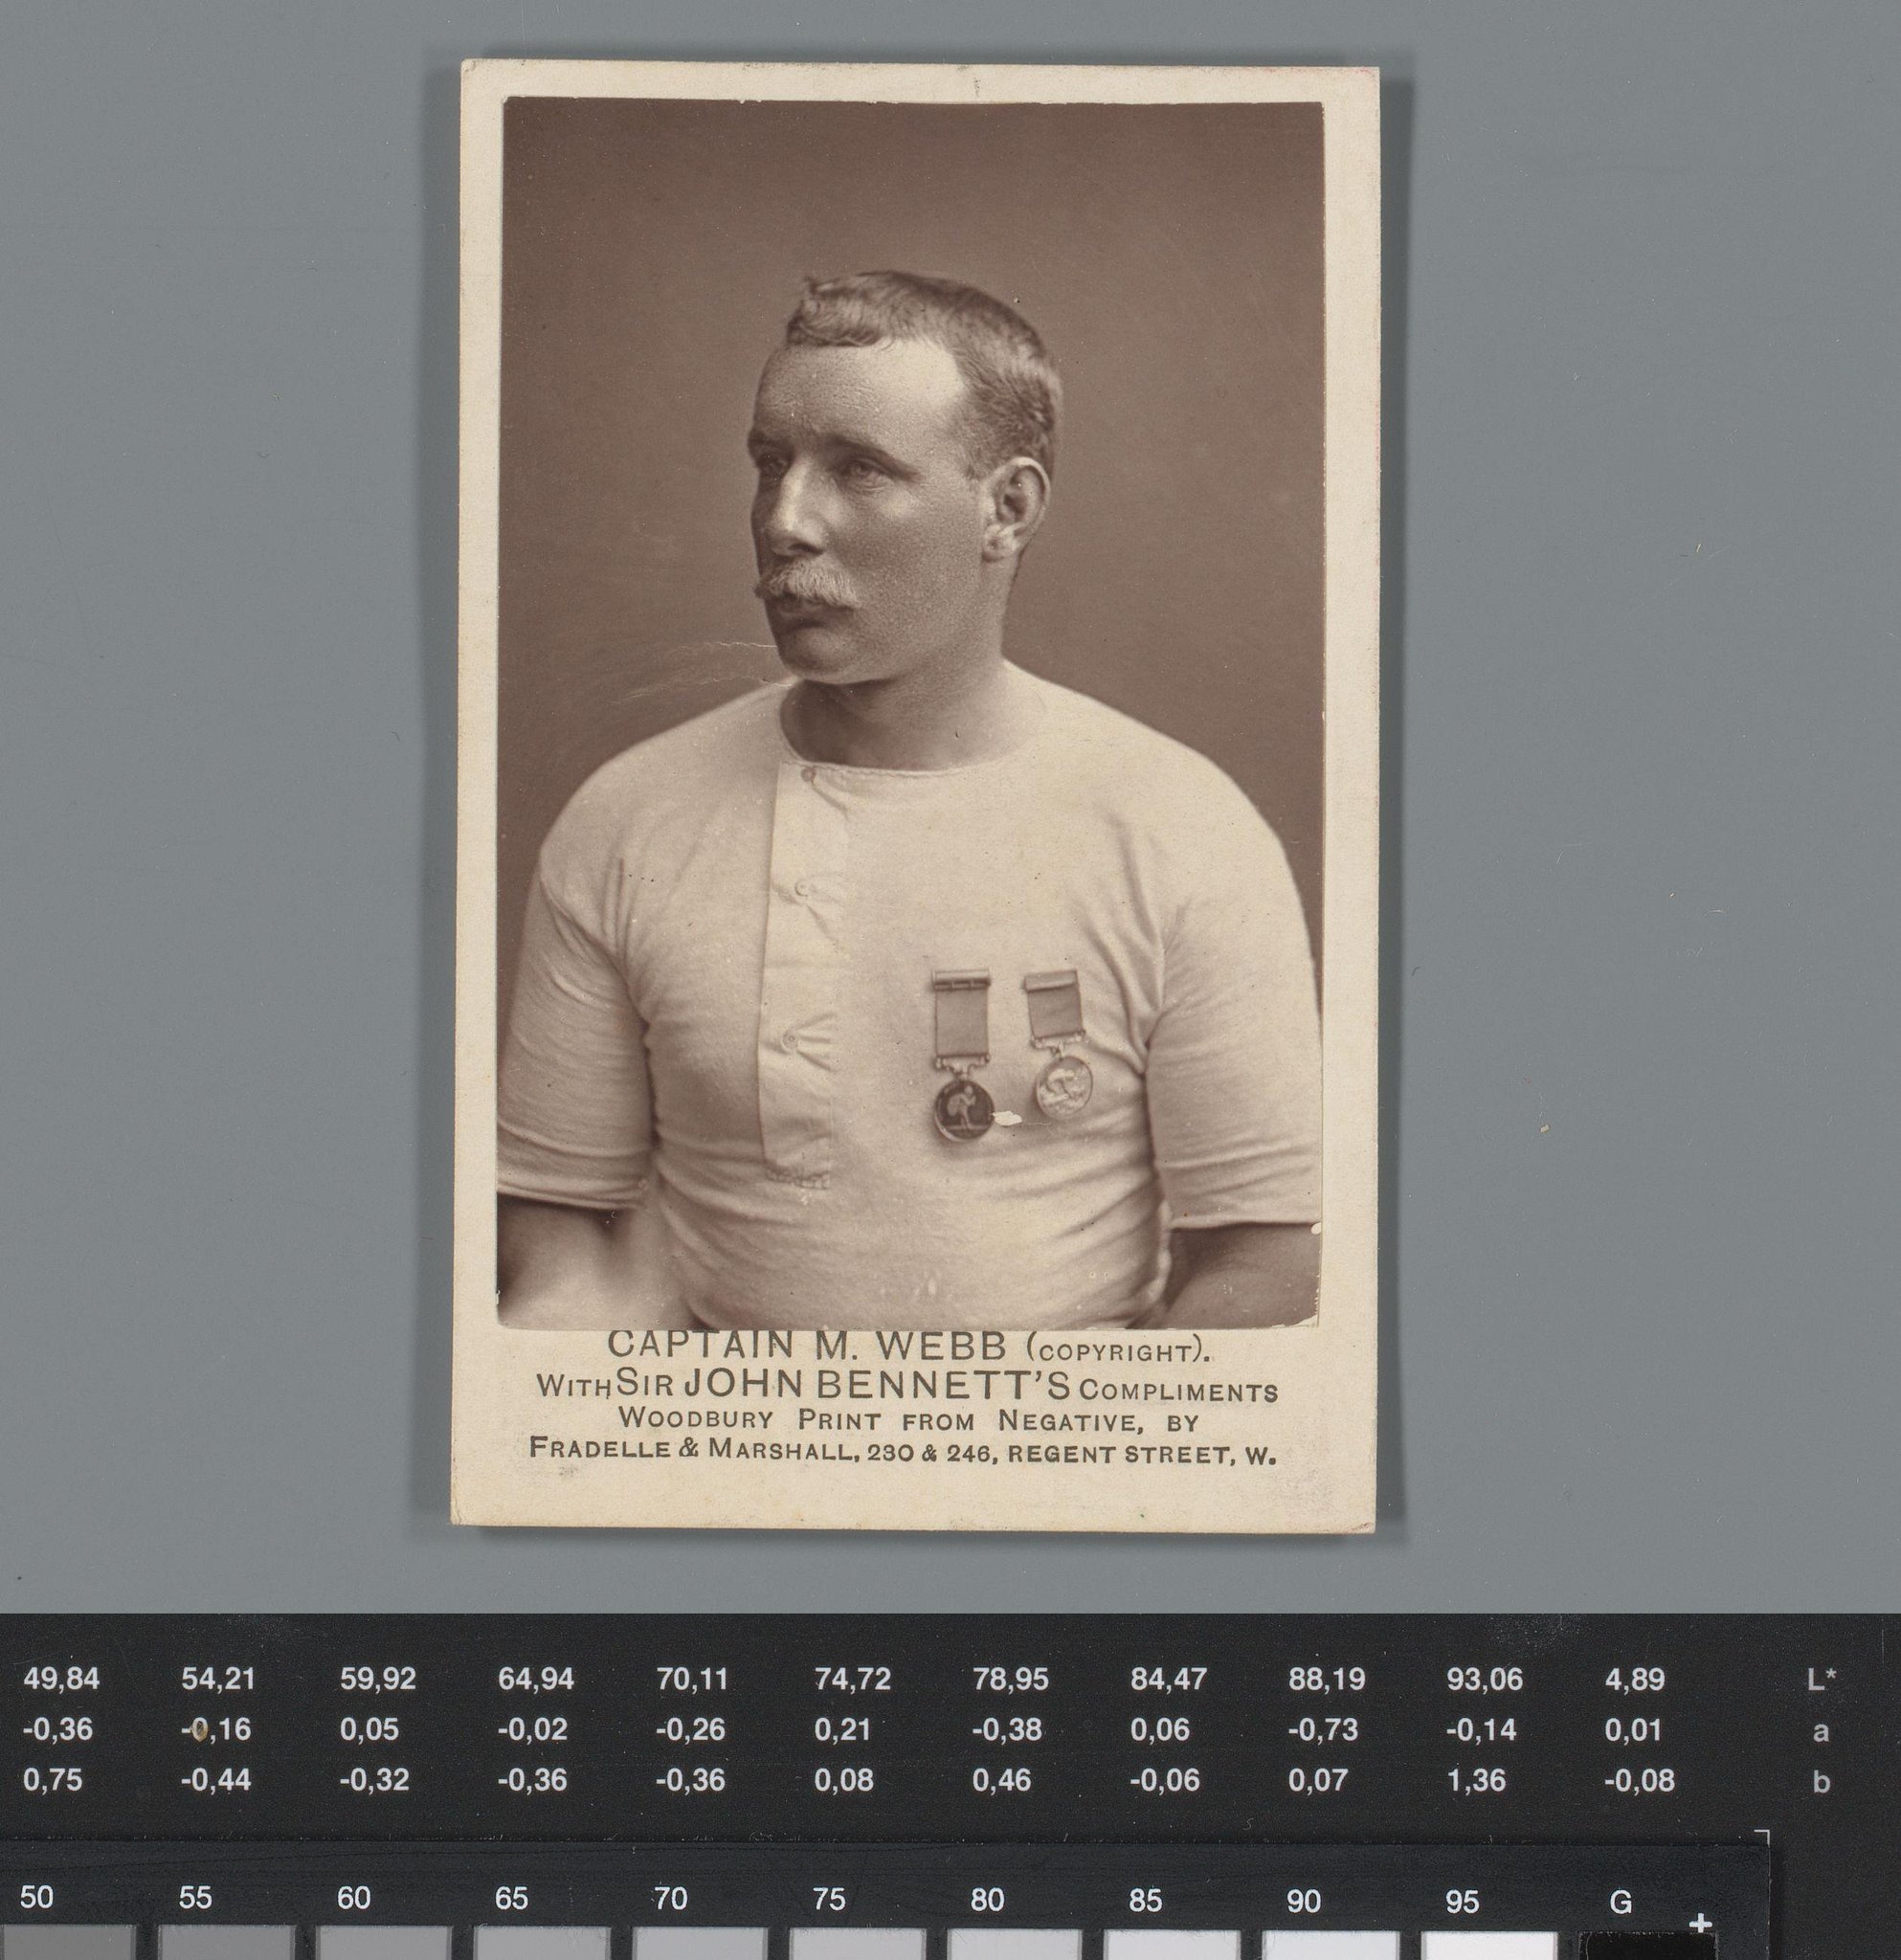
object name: carte de visite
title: Reclame voor horloges van John Bennett met portret van kapitein Matthew Webb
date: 1865-1900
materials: cardboard, photographic support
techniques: woodburytype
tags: advertising, historical persons, medals and other marks of military honour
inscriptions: inscription: ‘(...) Bennetts / WATCHES / 65. Cheapside (...) LONDON’